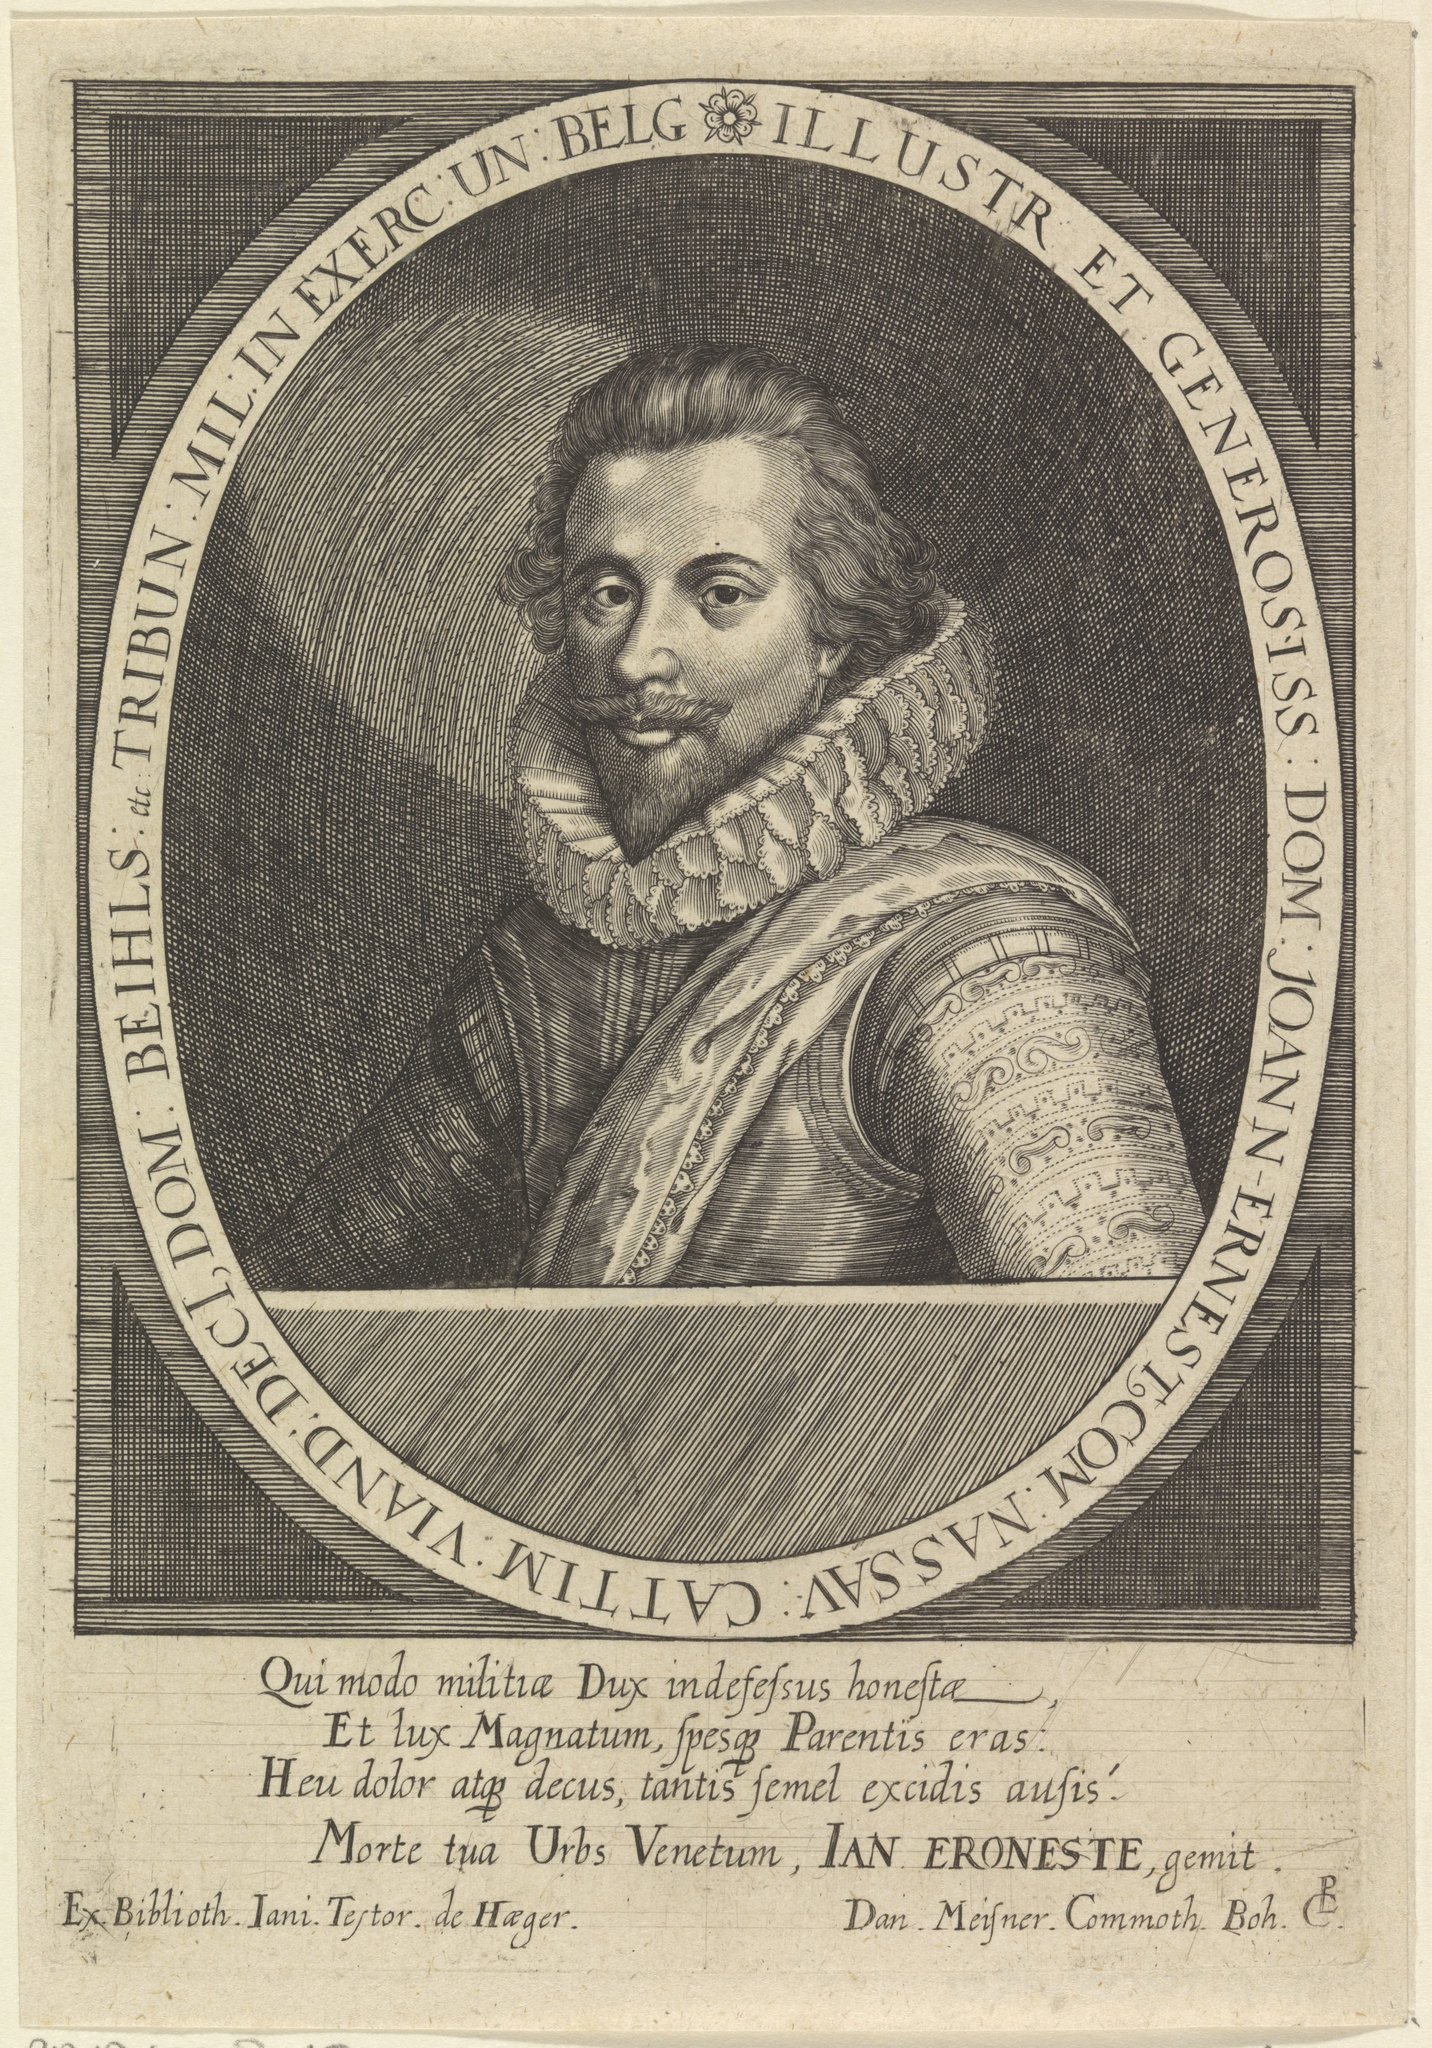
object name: print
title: Portret van Johan Ernst I, graaf van Nassau-Siegen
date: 1600-1637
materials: paper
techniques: engraving, etching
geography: utrecht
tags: johan ernst i graaf van nassau-siegen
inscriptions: collector's mark: Lugt 2228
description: De hier vermelde titel verwijst naar de hoogst verkregen titel van de geportretteerde, niet per se naar de titel die de geportretteerde op deze voorstelling draagt.